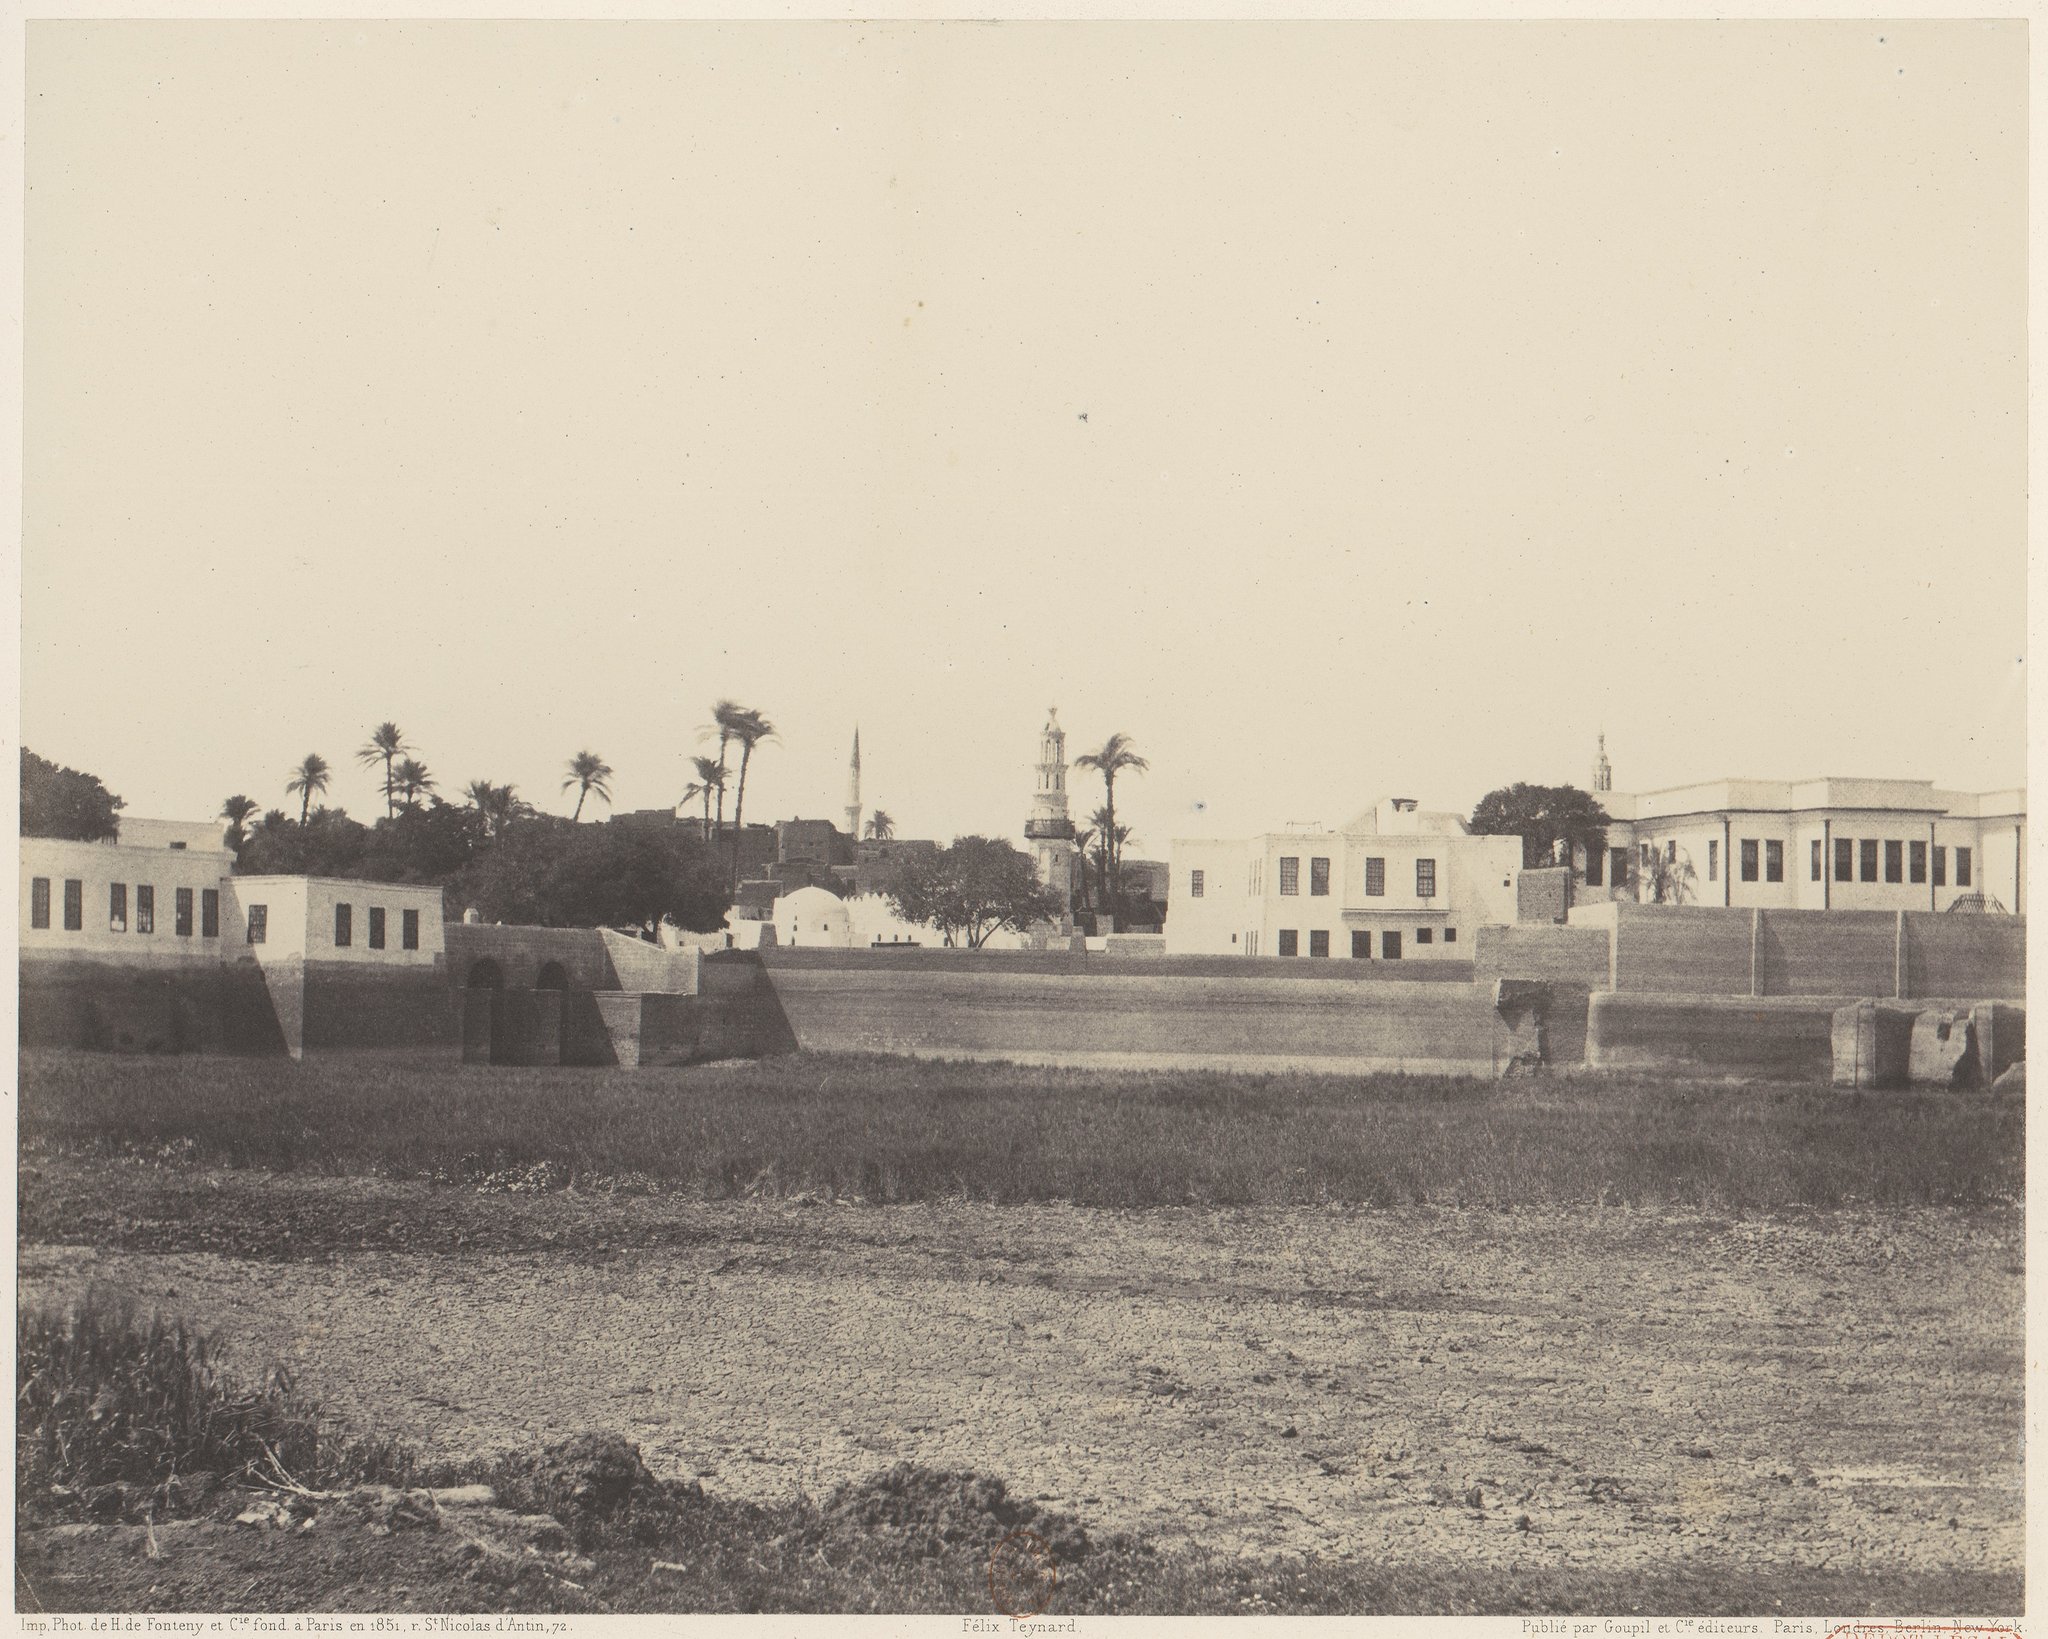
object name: photograph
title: Syout, Constructions Modernes - le Divan, etc.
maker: félix teynard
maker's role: artist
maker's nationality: french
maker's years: 1817-1892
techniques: paper negative, salted paper print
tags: architecture,buildings